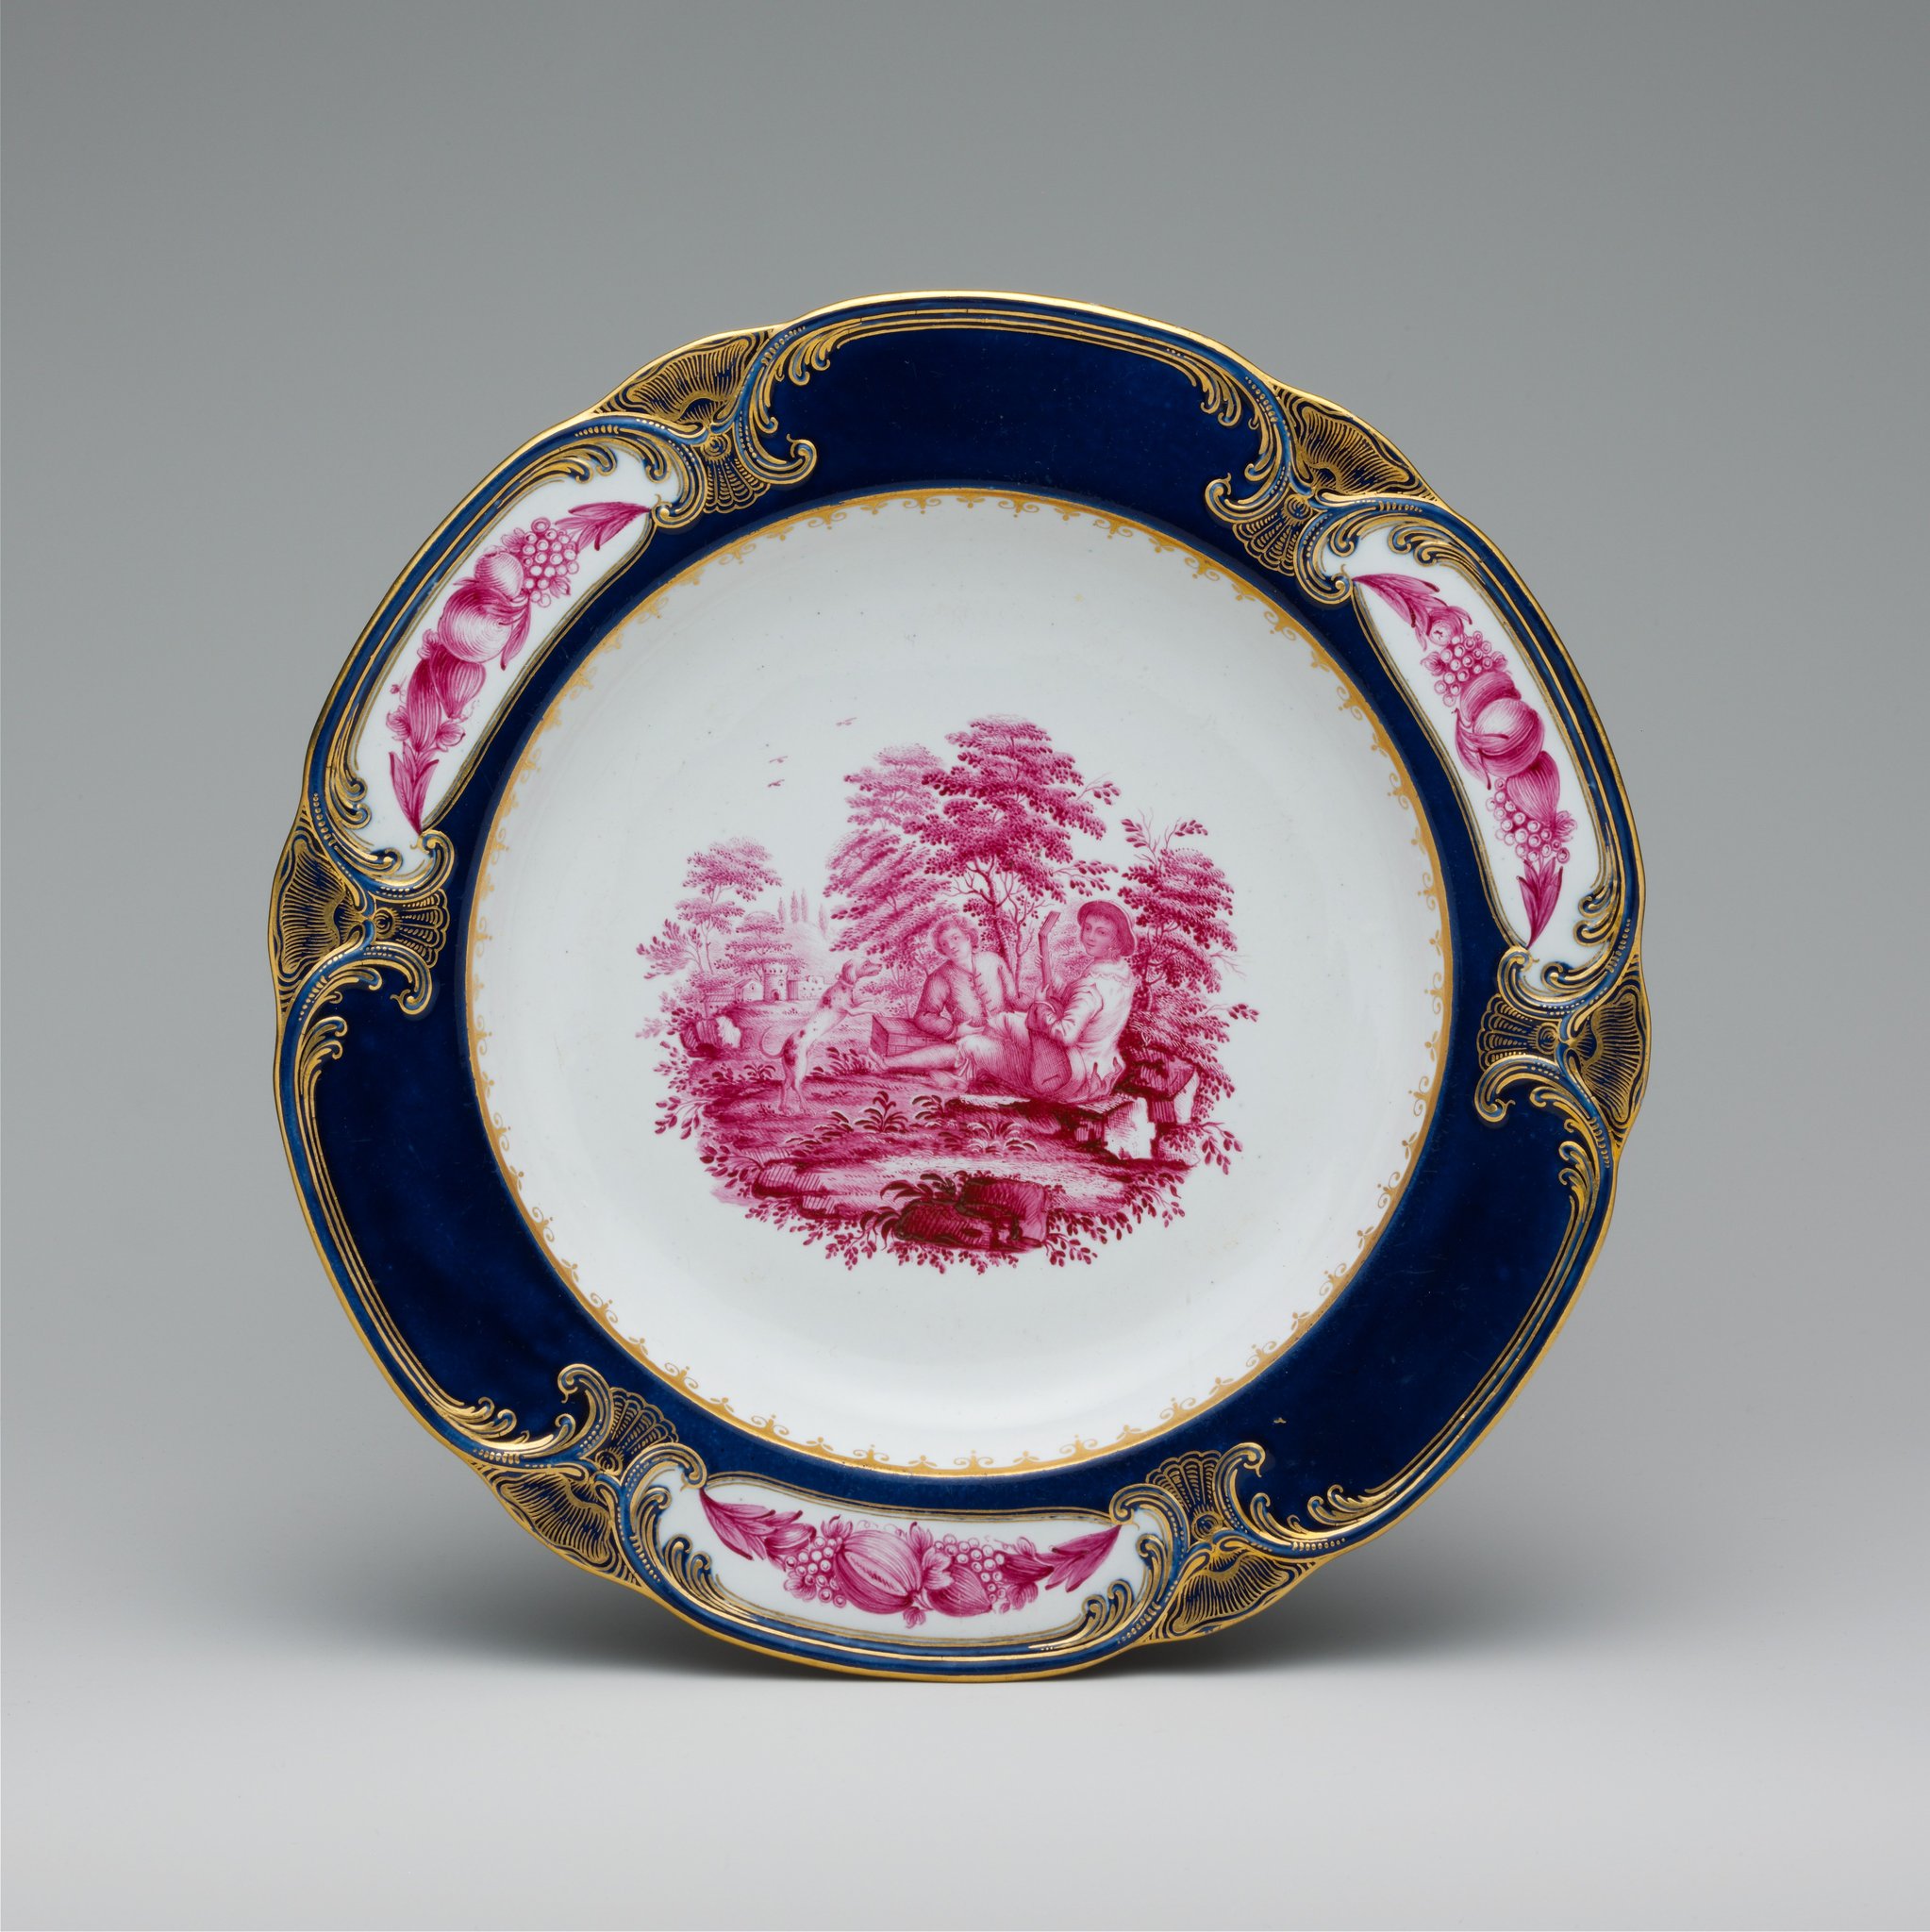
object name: dish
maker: doccia porcelain manufactory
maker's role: manufactory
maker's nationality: italian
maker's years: 1737-1896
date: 1760-1770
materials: hard paste porcelain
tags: men,women,dogs,trees